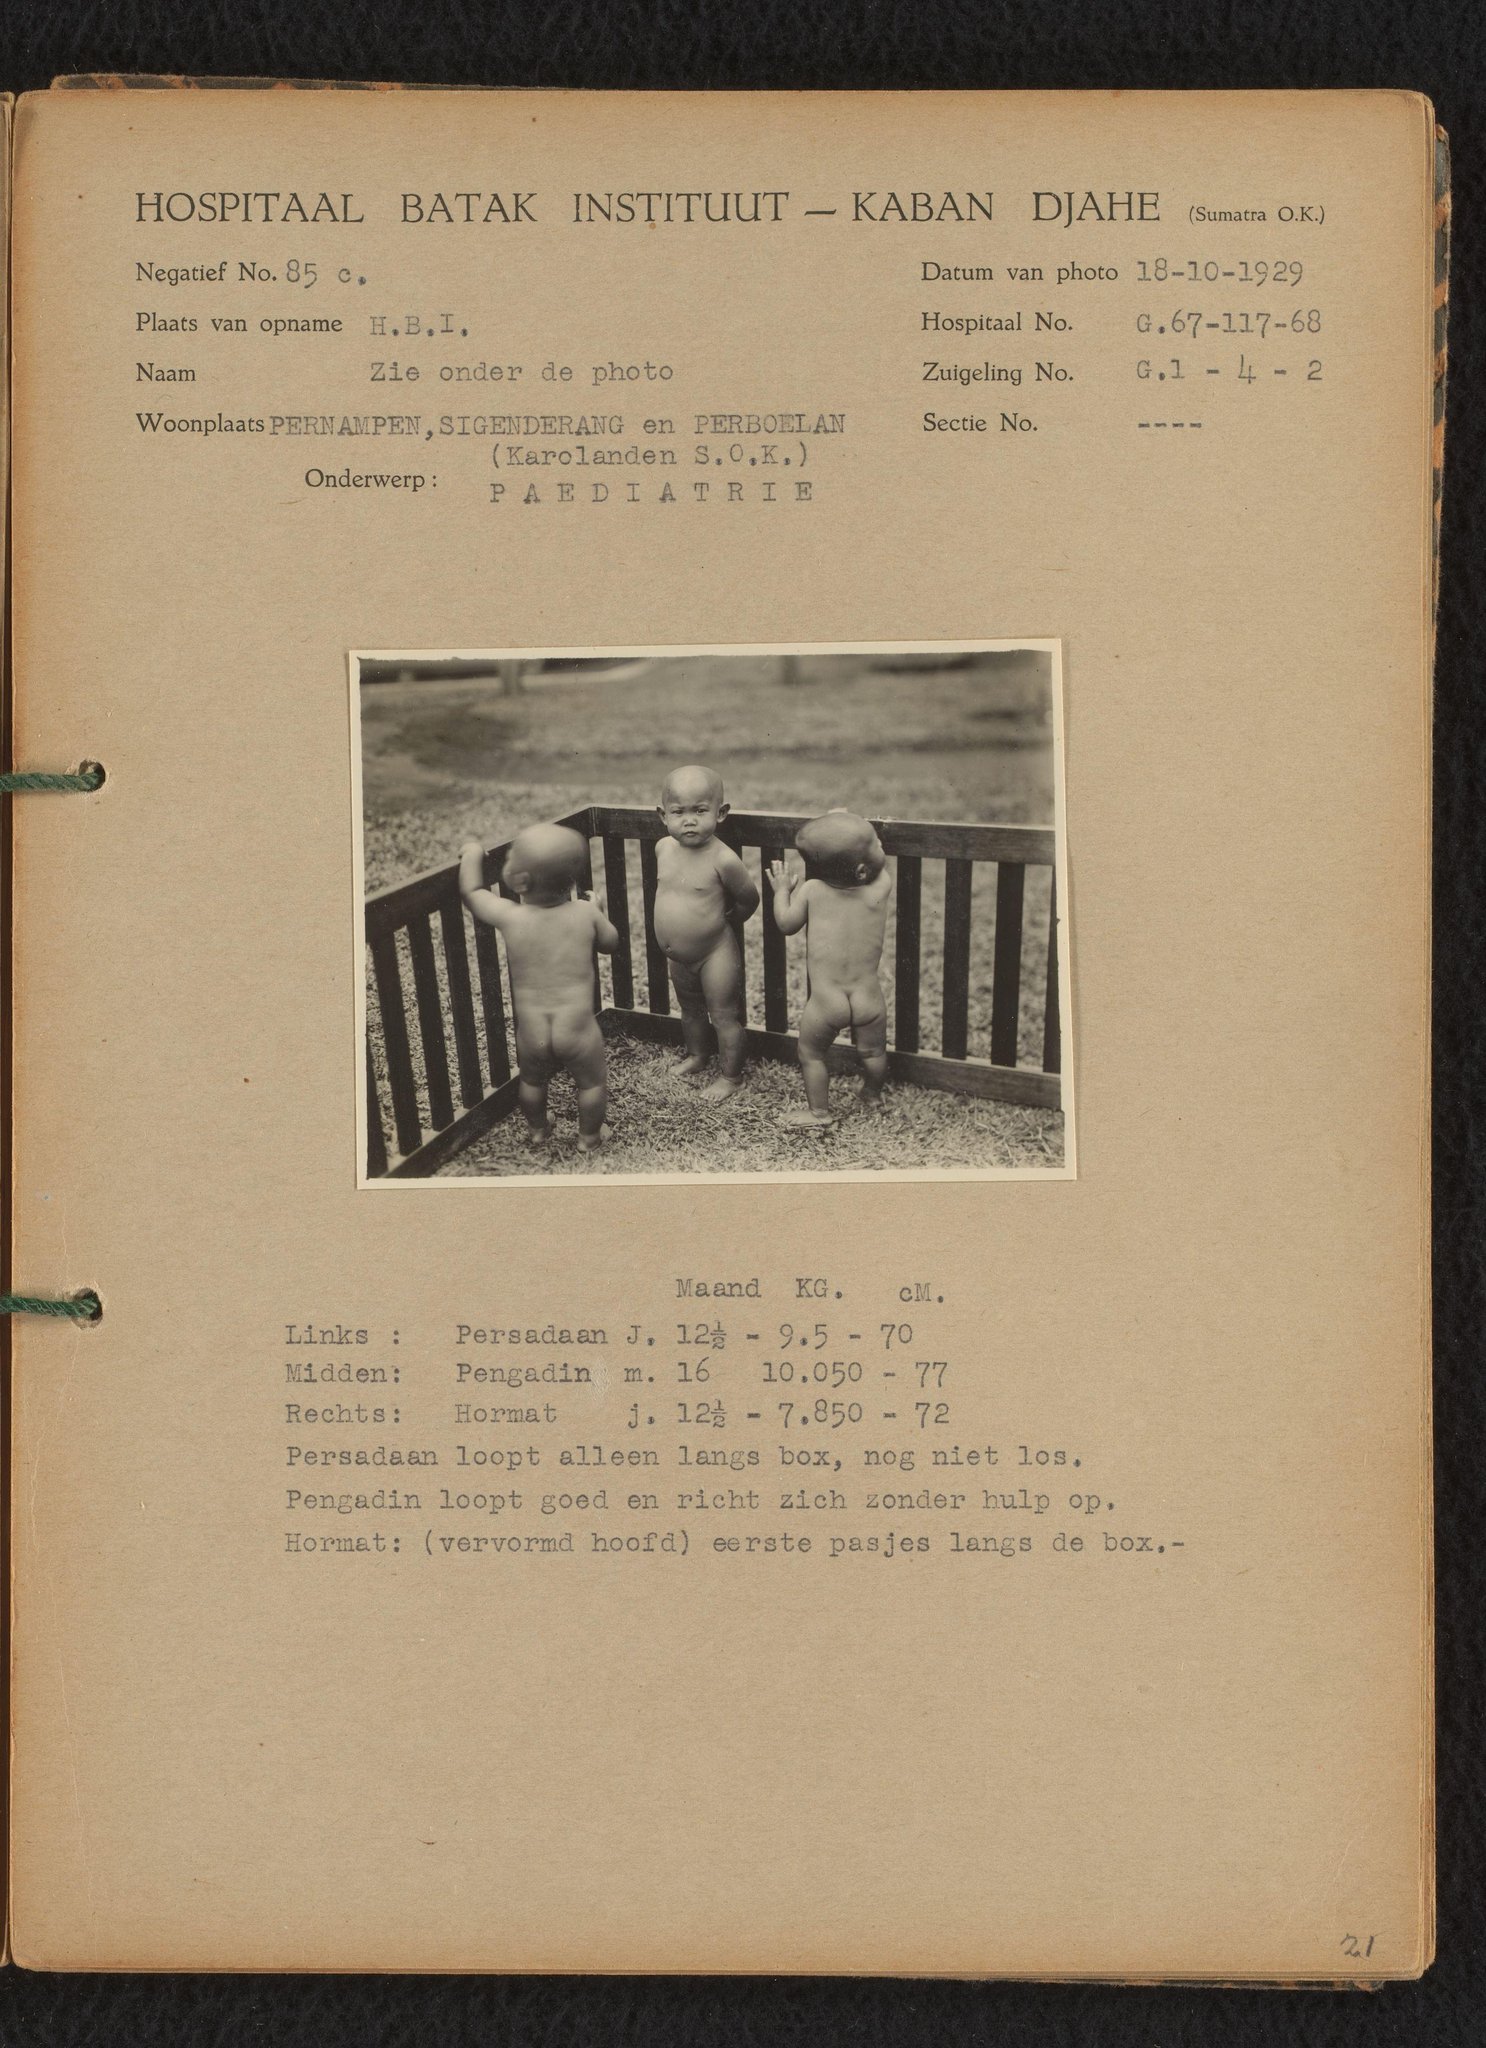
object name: photograph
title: Drie kinderen in een box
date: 1929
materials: cardboard, photographic support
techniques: gelatin silver print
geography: kabanjahe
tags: colonial system, play-pen, patient, sick person, infant, baby ~ the ages of man, sumatra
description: Medische foto van drie kinderen van 12 en 16 maanden van de afdeling pediatrie die in een box in de tuin leren lopen. Datum foto: 18 november 1929. Foto geplakt op voorgedrukt kartonnen blad ingebonden in het fotoalbum over het Hospitaal Batak Instituut te Kabanjaheh op Sumatra in de jaren 1926-1929.